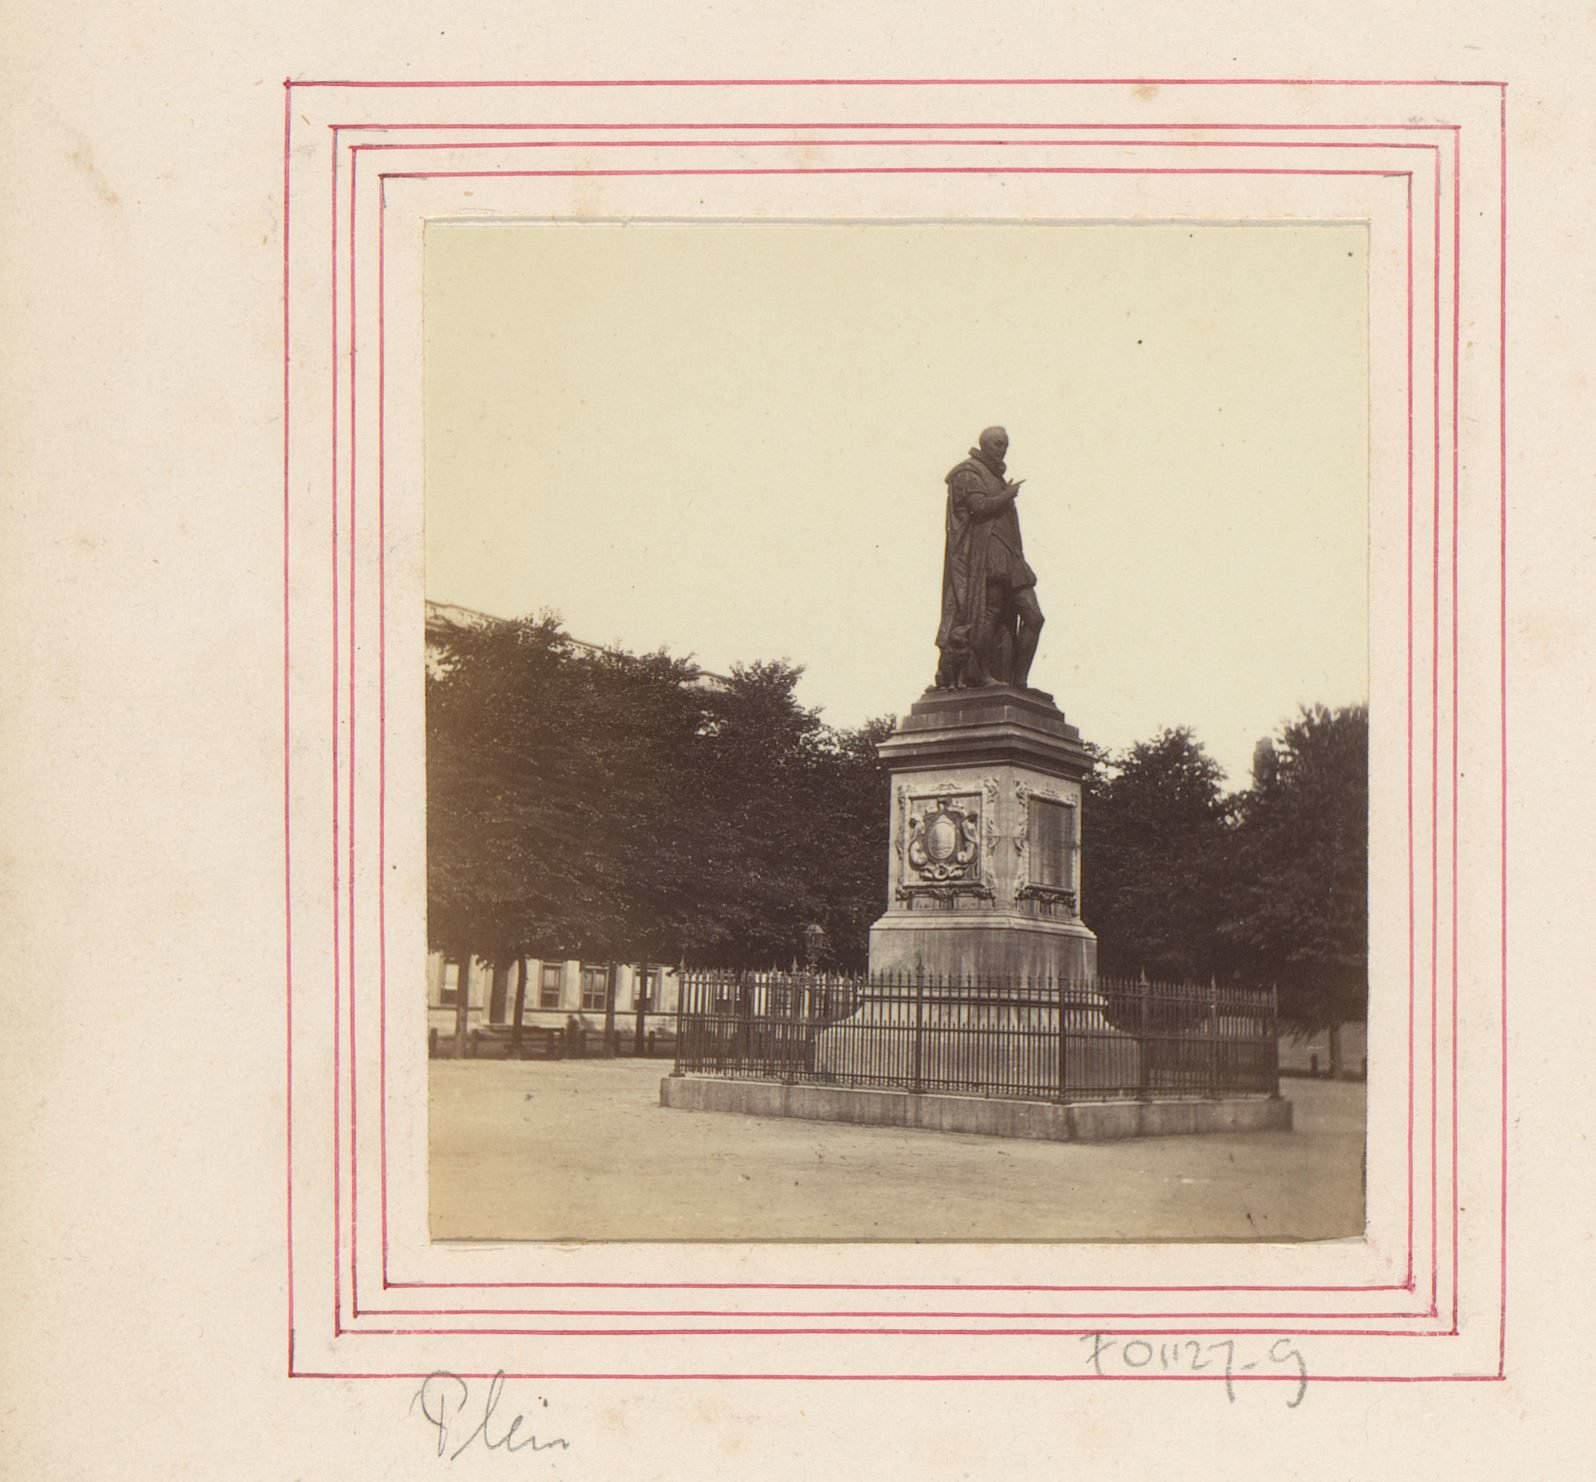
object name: photograph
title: Standbeeld van Willem van Oranje op het Plein in Den Haag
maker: Anonymous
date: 1870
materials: photographic support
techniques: albumen print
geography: plein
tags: delft, william i (prince of orange), monument, statue, square, place, circus, etc. (+ city(-scape) with figures, staffage)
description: Onderdeel van Album met foto's en litho's van bezienswaardigheden in Noord- en Zuid-Hollandse steden, schilderijen en klederdrachten.